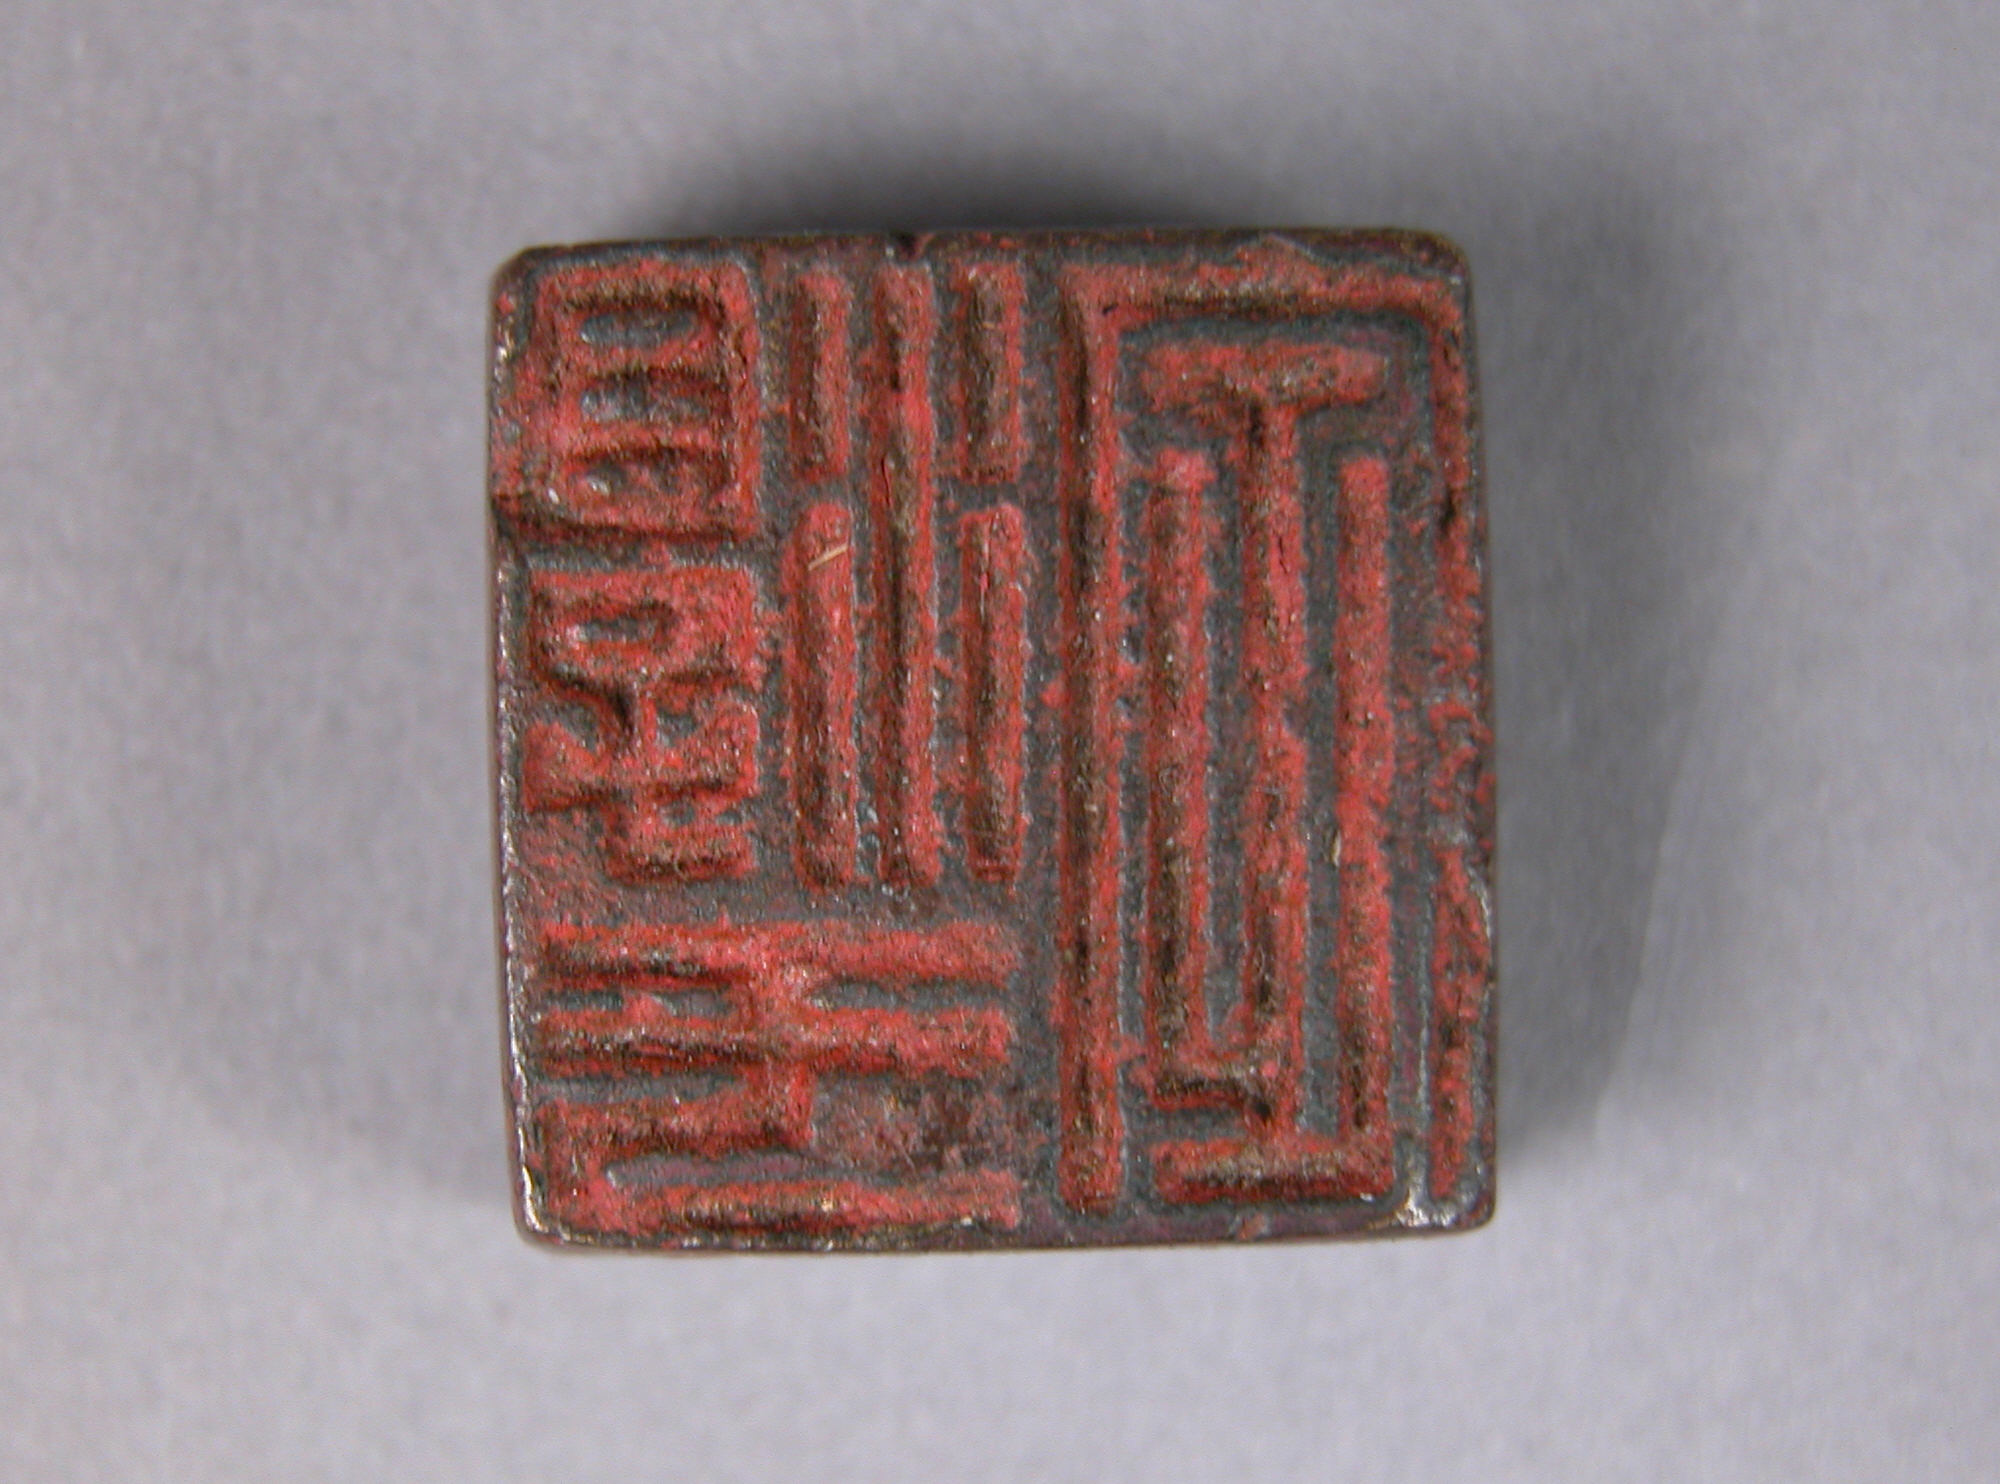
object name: seal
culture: chinese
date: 1368-1644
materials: bronze